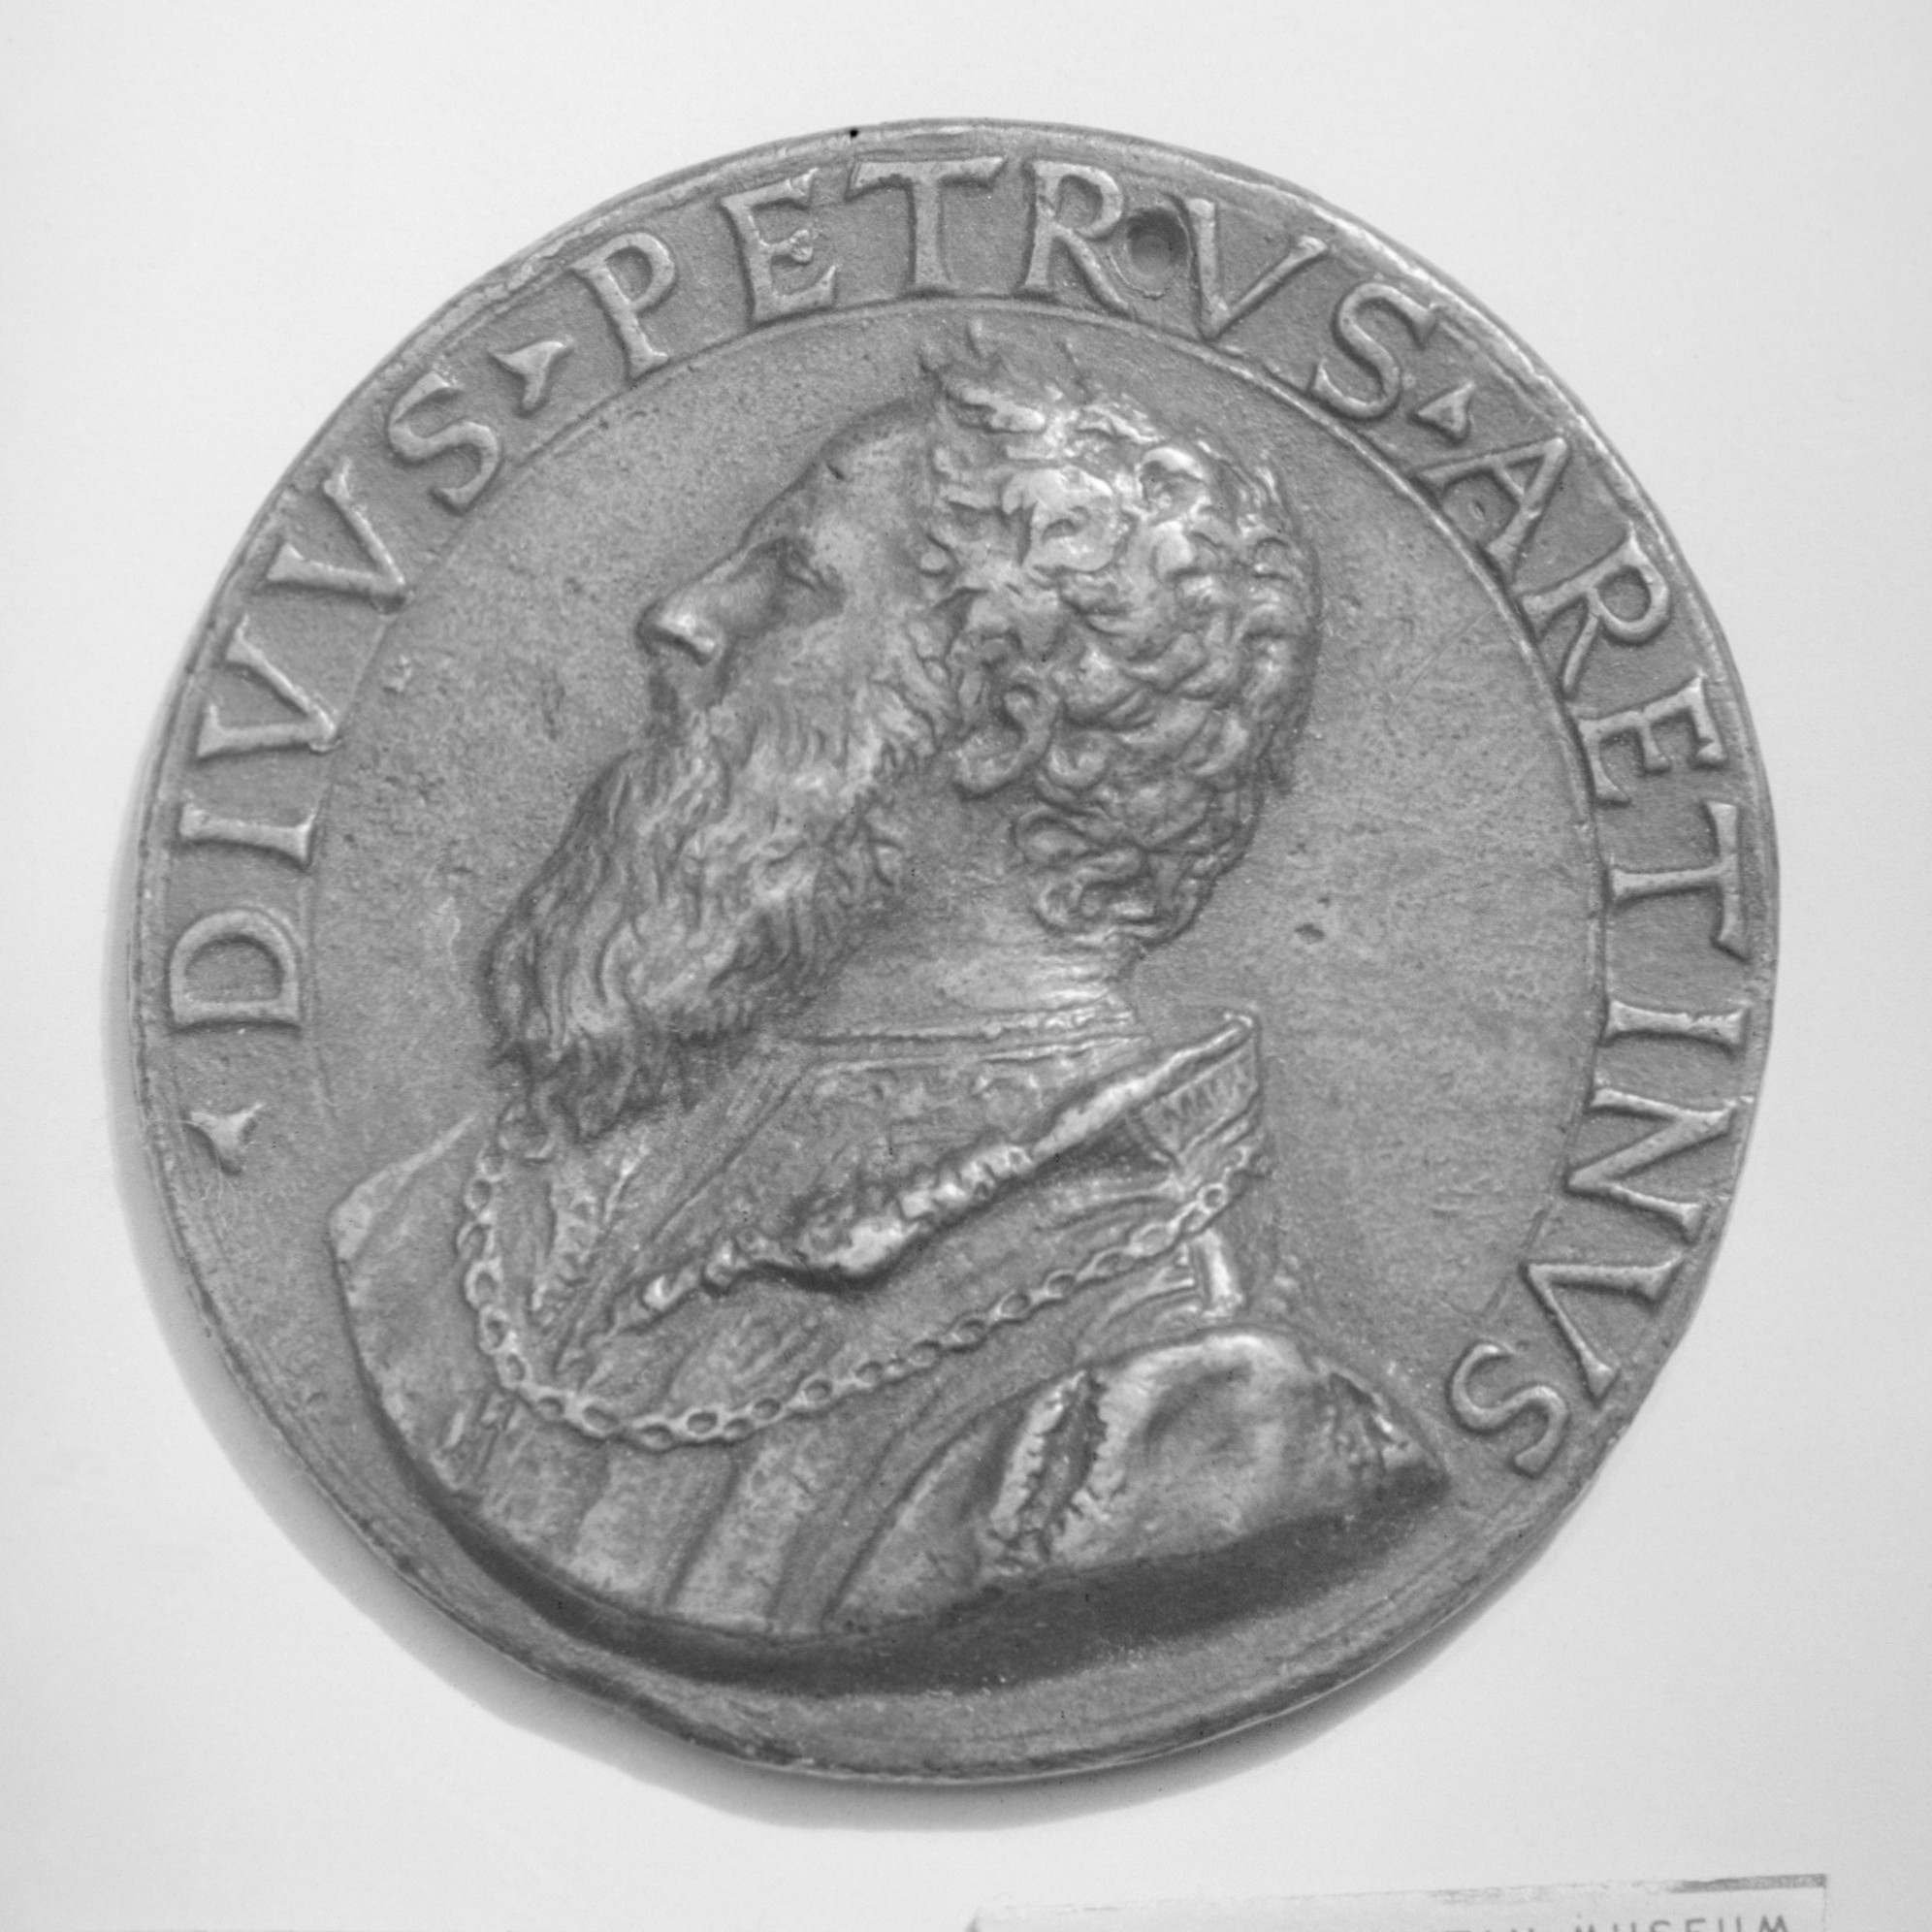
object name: medal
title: Pietro Aretino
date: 1526-1550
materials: bronze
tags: men,male nudes,profiles